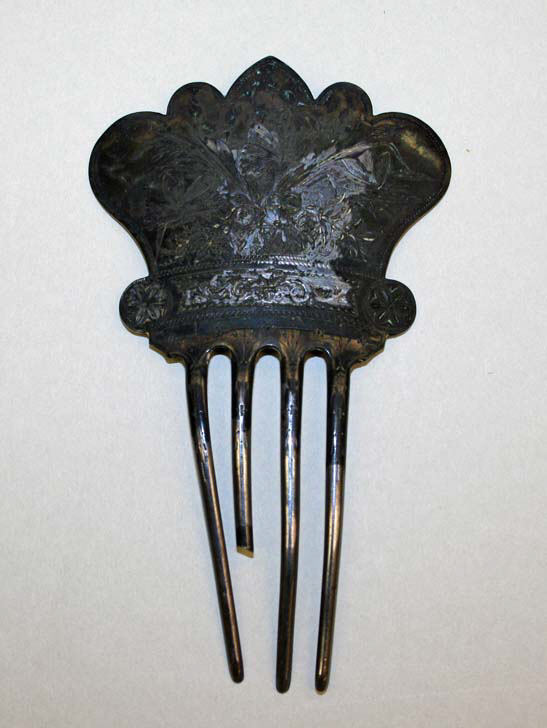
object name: comb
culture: american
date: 1878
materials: metal